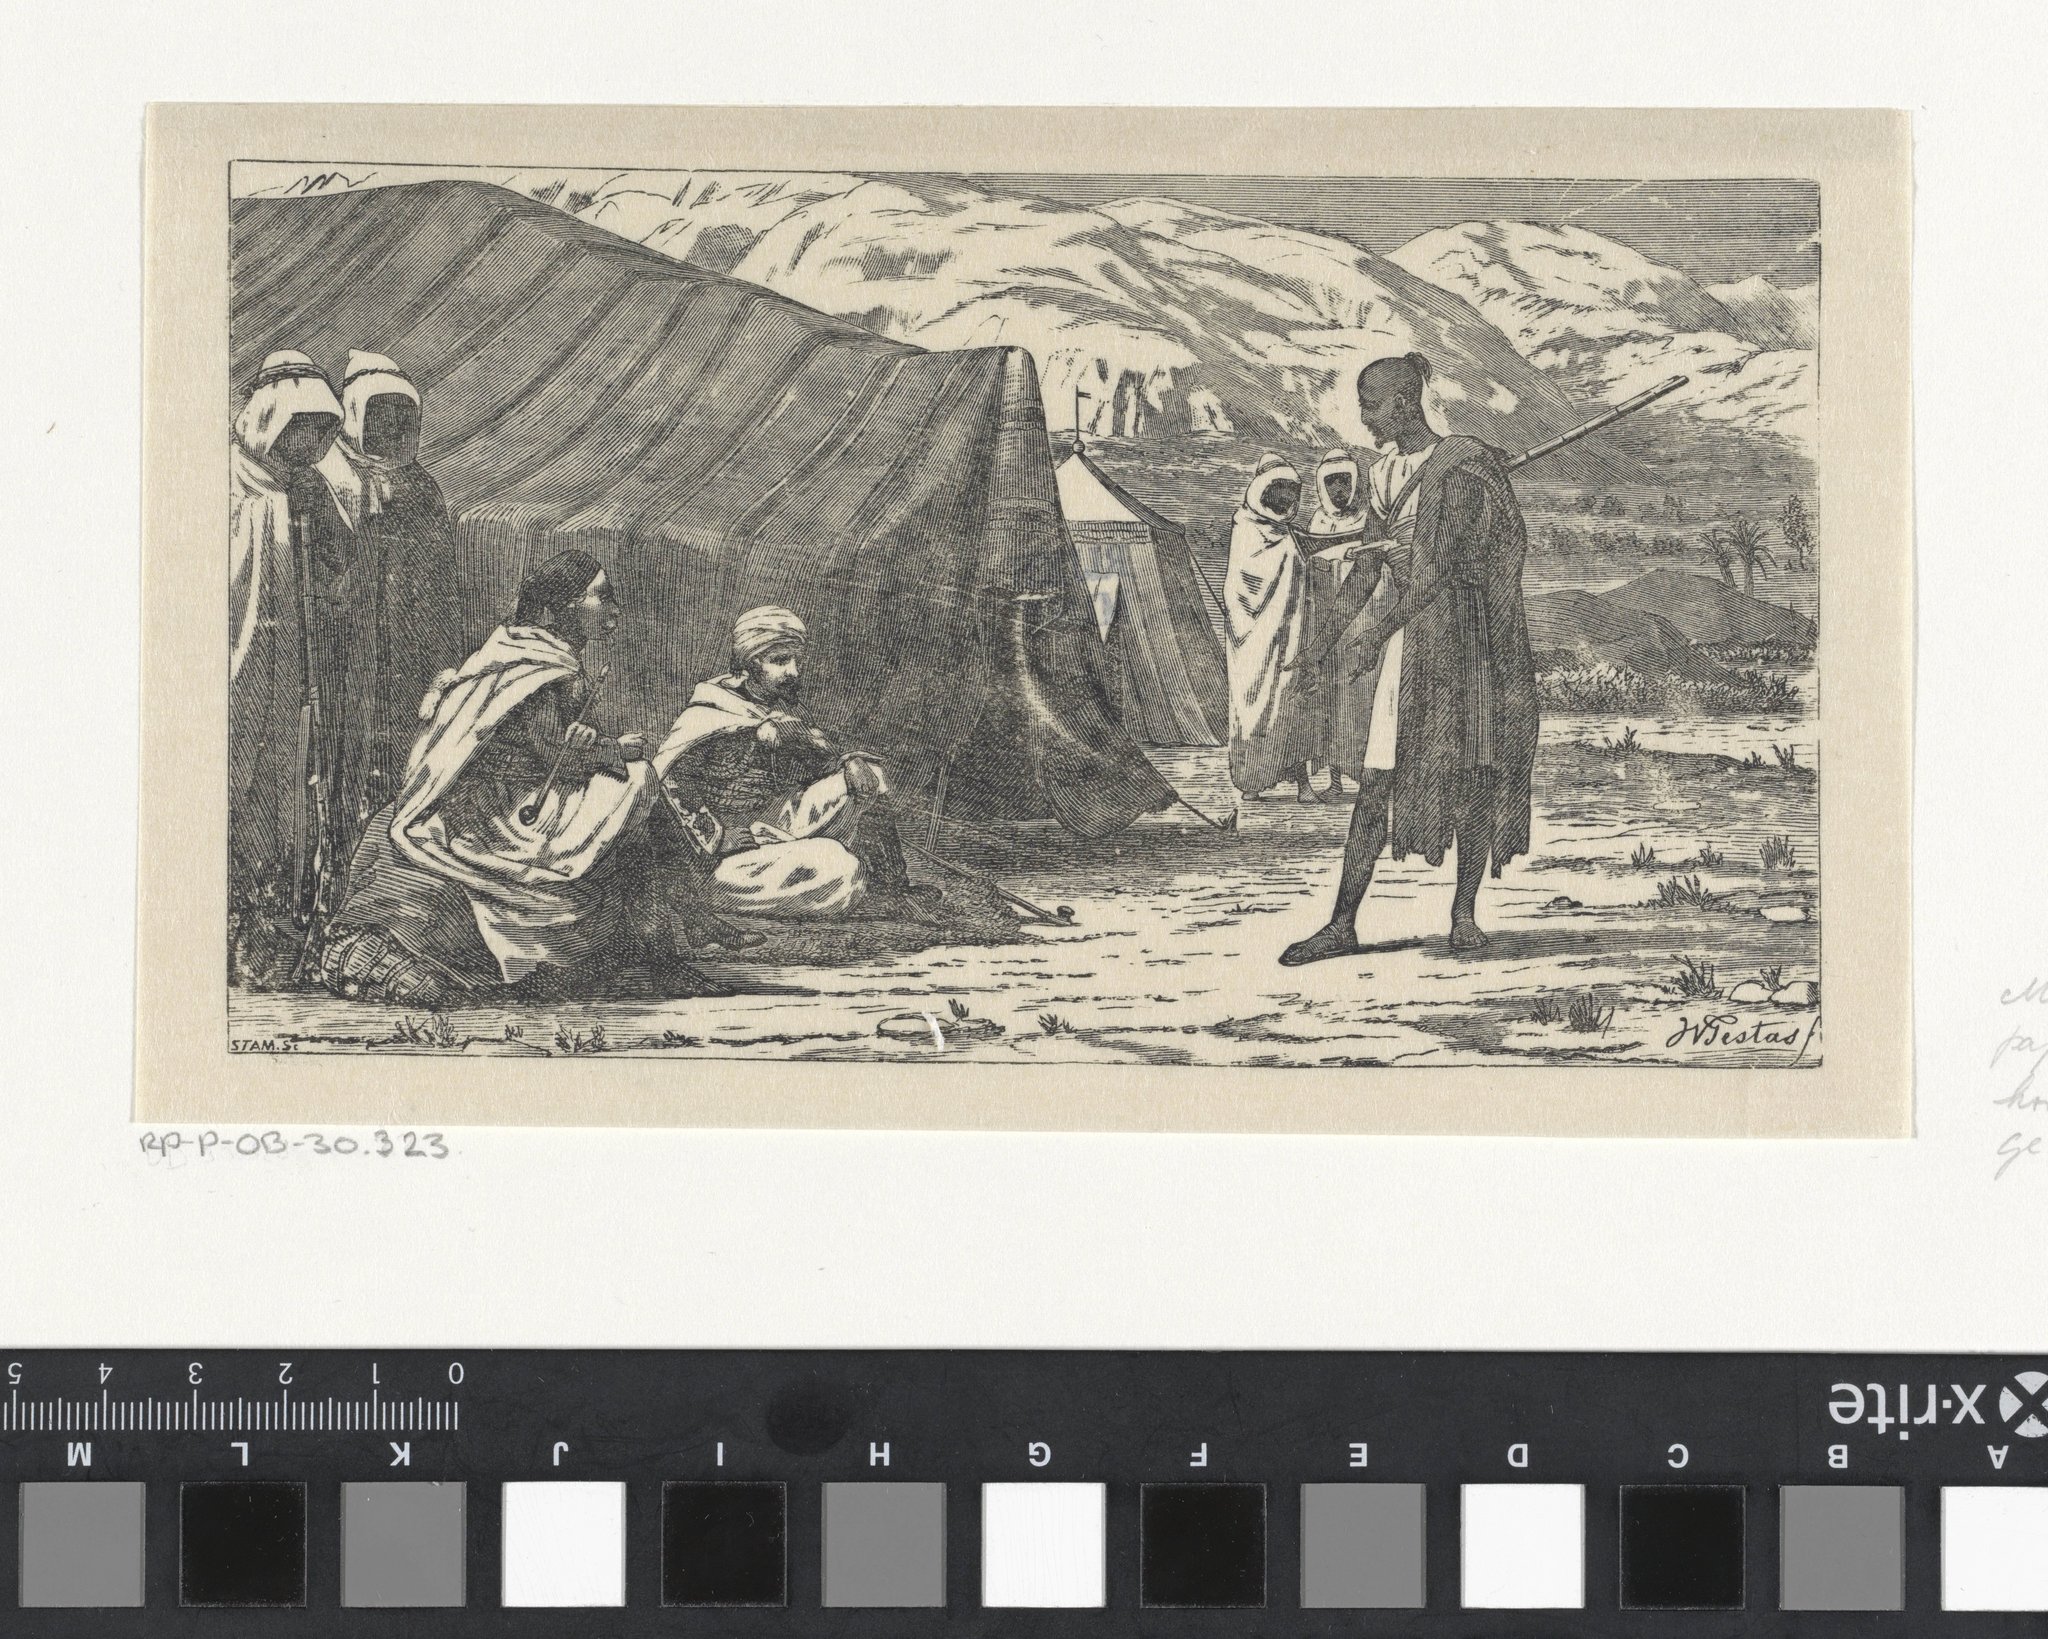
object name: print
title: Figuren in Oosterse kleding bij een tentenkamp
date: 1841-1874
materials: paper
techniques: engraving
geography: the hague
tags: head-gear: turban, human races, peoples and nationalities (other than prehistoric or extinct), tent-camp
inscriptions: collector's mark: Lugt 2166